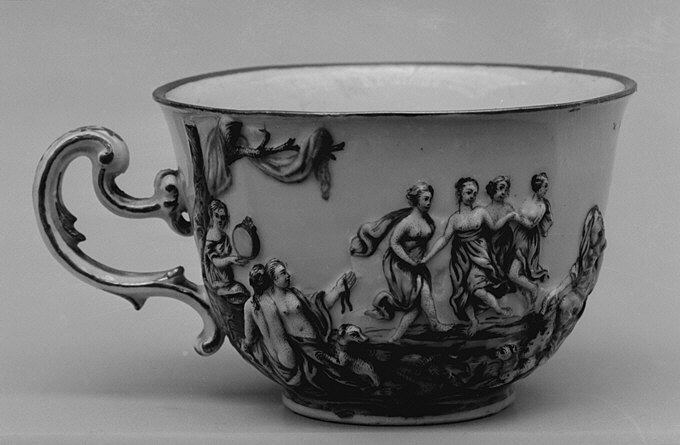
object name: teacup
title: Tea cup (part of a service)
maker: doccia porcelain manufactory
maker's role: manufactory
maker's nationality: italian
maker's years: 1737-1896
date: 1760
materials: hard paste porcelain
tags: women